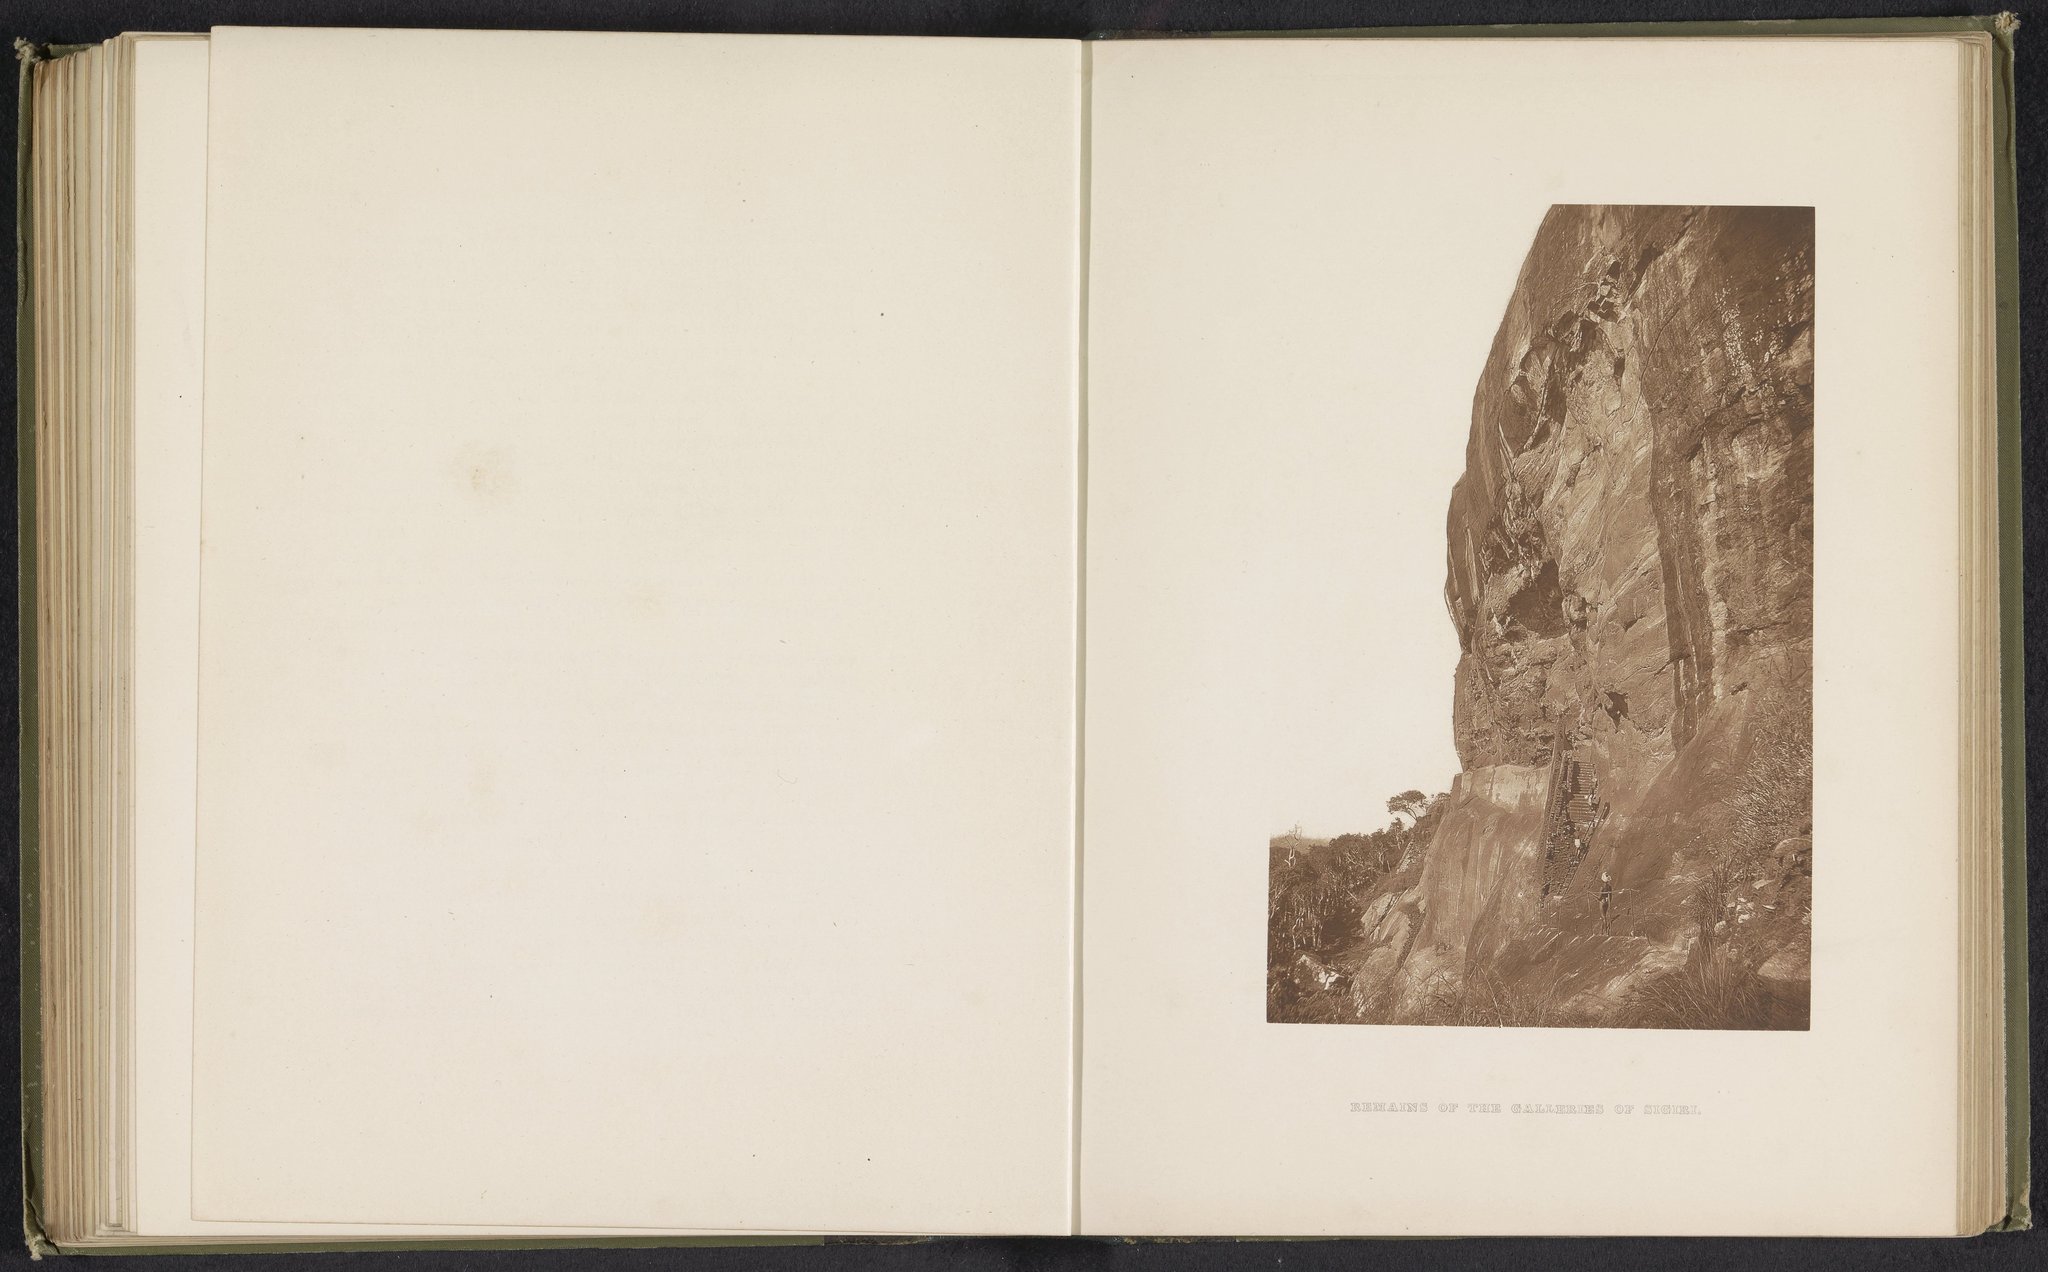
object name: photomechanical print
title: View of the gallery at the Lion Rock, Sigiriya, Sri Lanka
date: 1896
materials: paper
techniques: woodburygravure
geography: sigiriya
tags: rock-formations, ruin of a dwelling, house, castle, etc.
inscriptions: title: ‘REMAINS OF THE GALLERIES OF SIGIRI.’